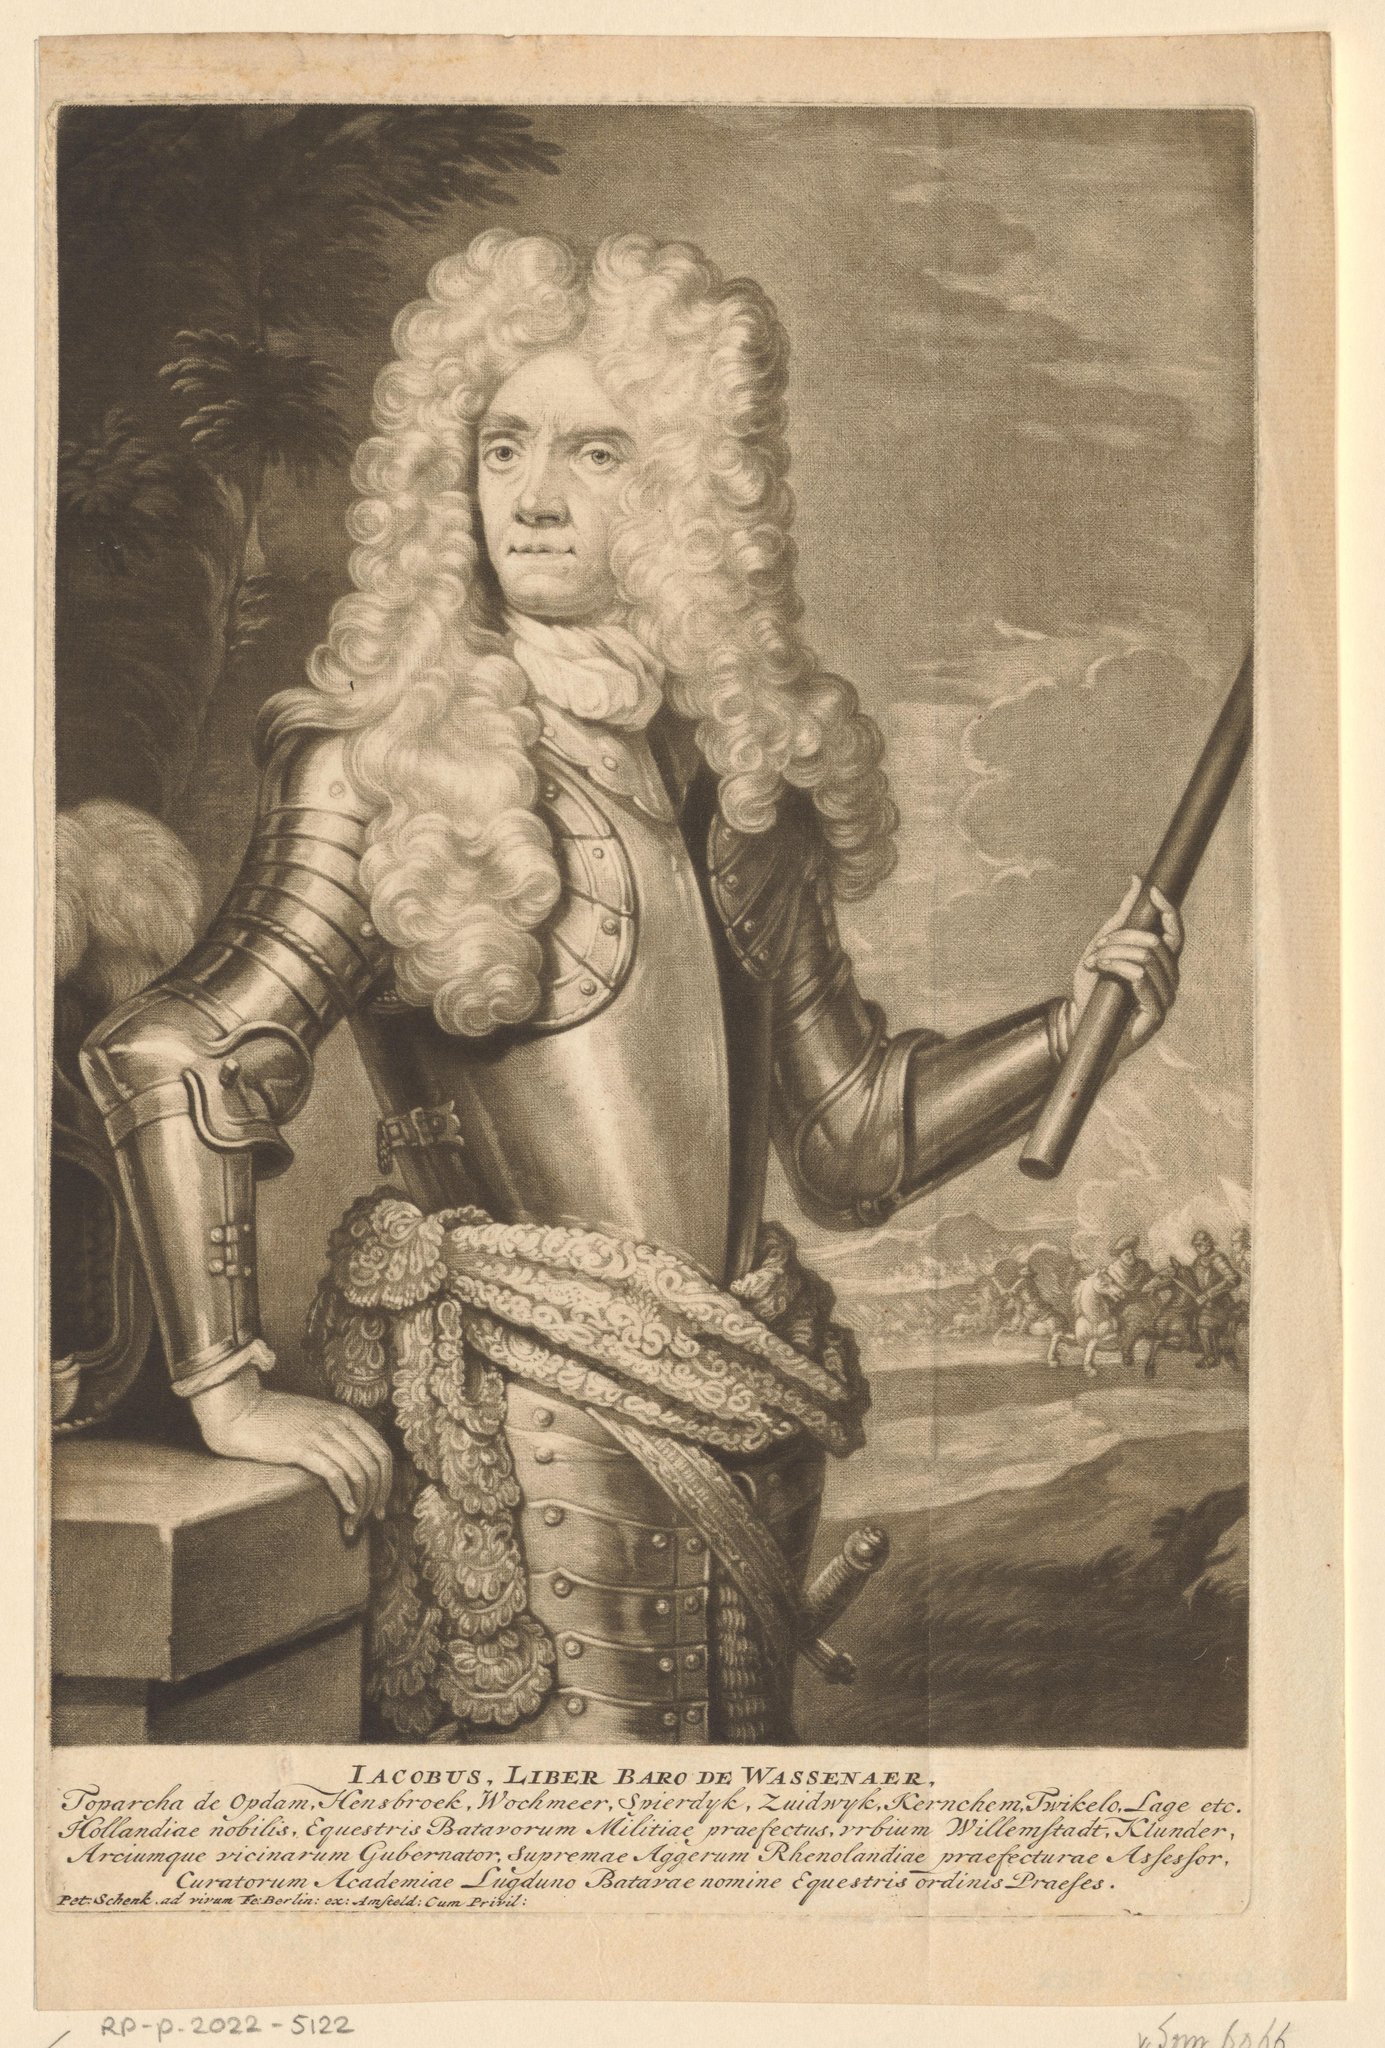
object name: print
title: Portret van Jacob II, baron van Wassenaer, heer van Obdam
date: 1700-1711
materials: paper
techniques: engraving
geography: berlin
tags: the hague, armour, historical persons, battle, baton of general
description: Met een vierregelig onderschrift in het Latijn.